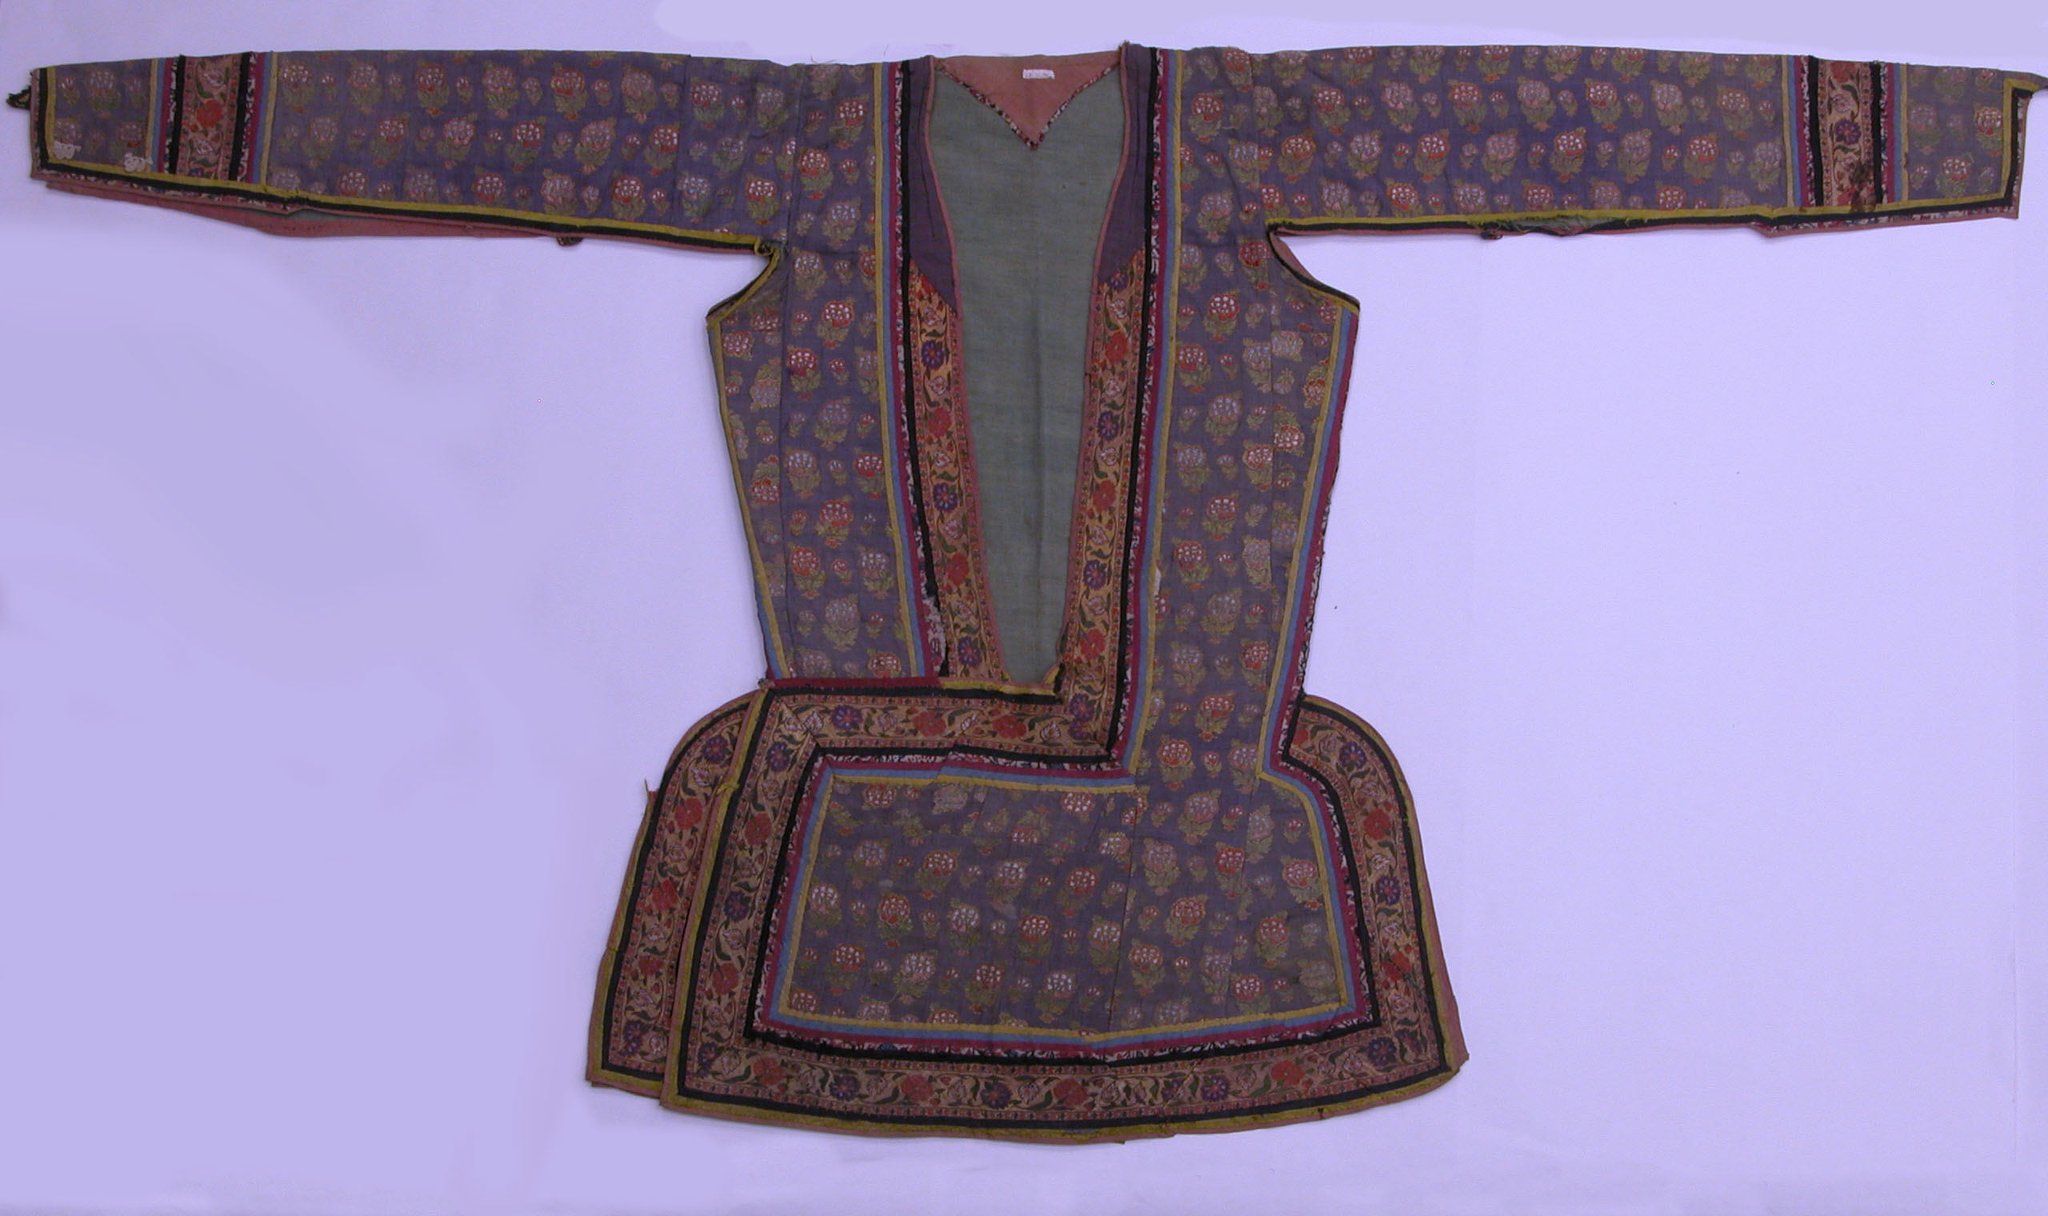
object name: coat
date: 1701-1800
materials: cotton, metal thread, silk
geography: iran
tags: flowers